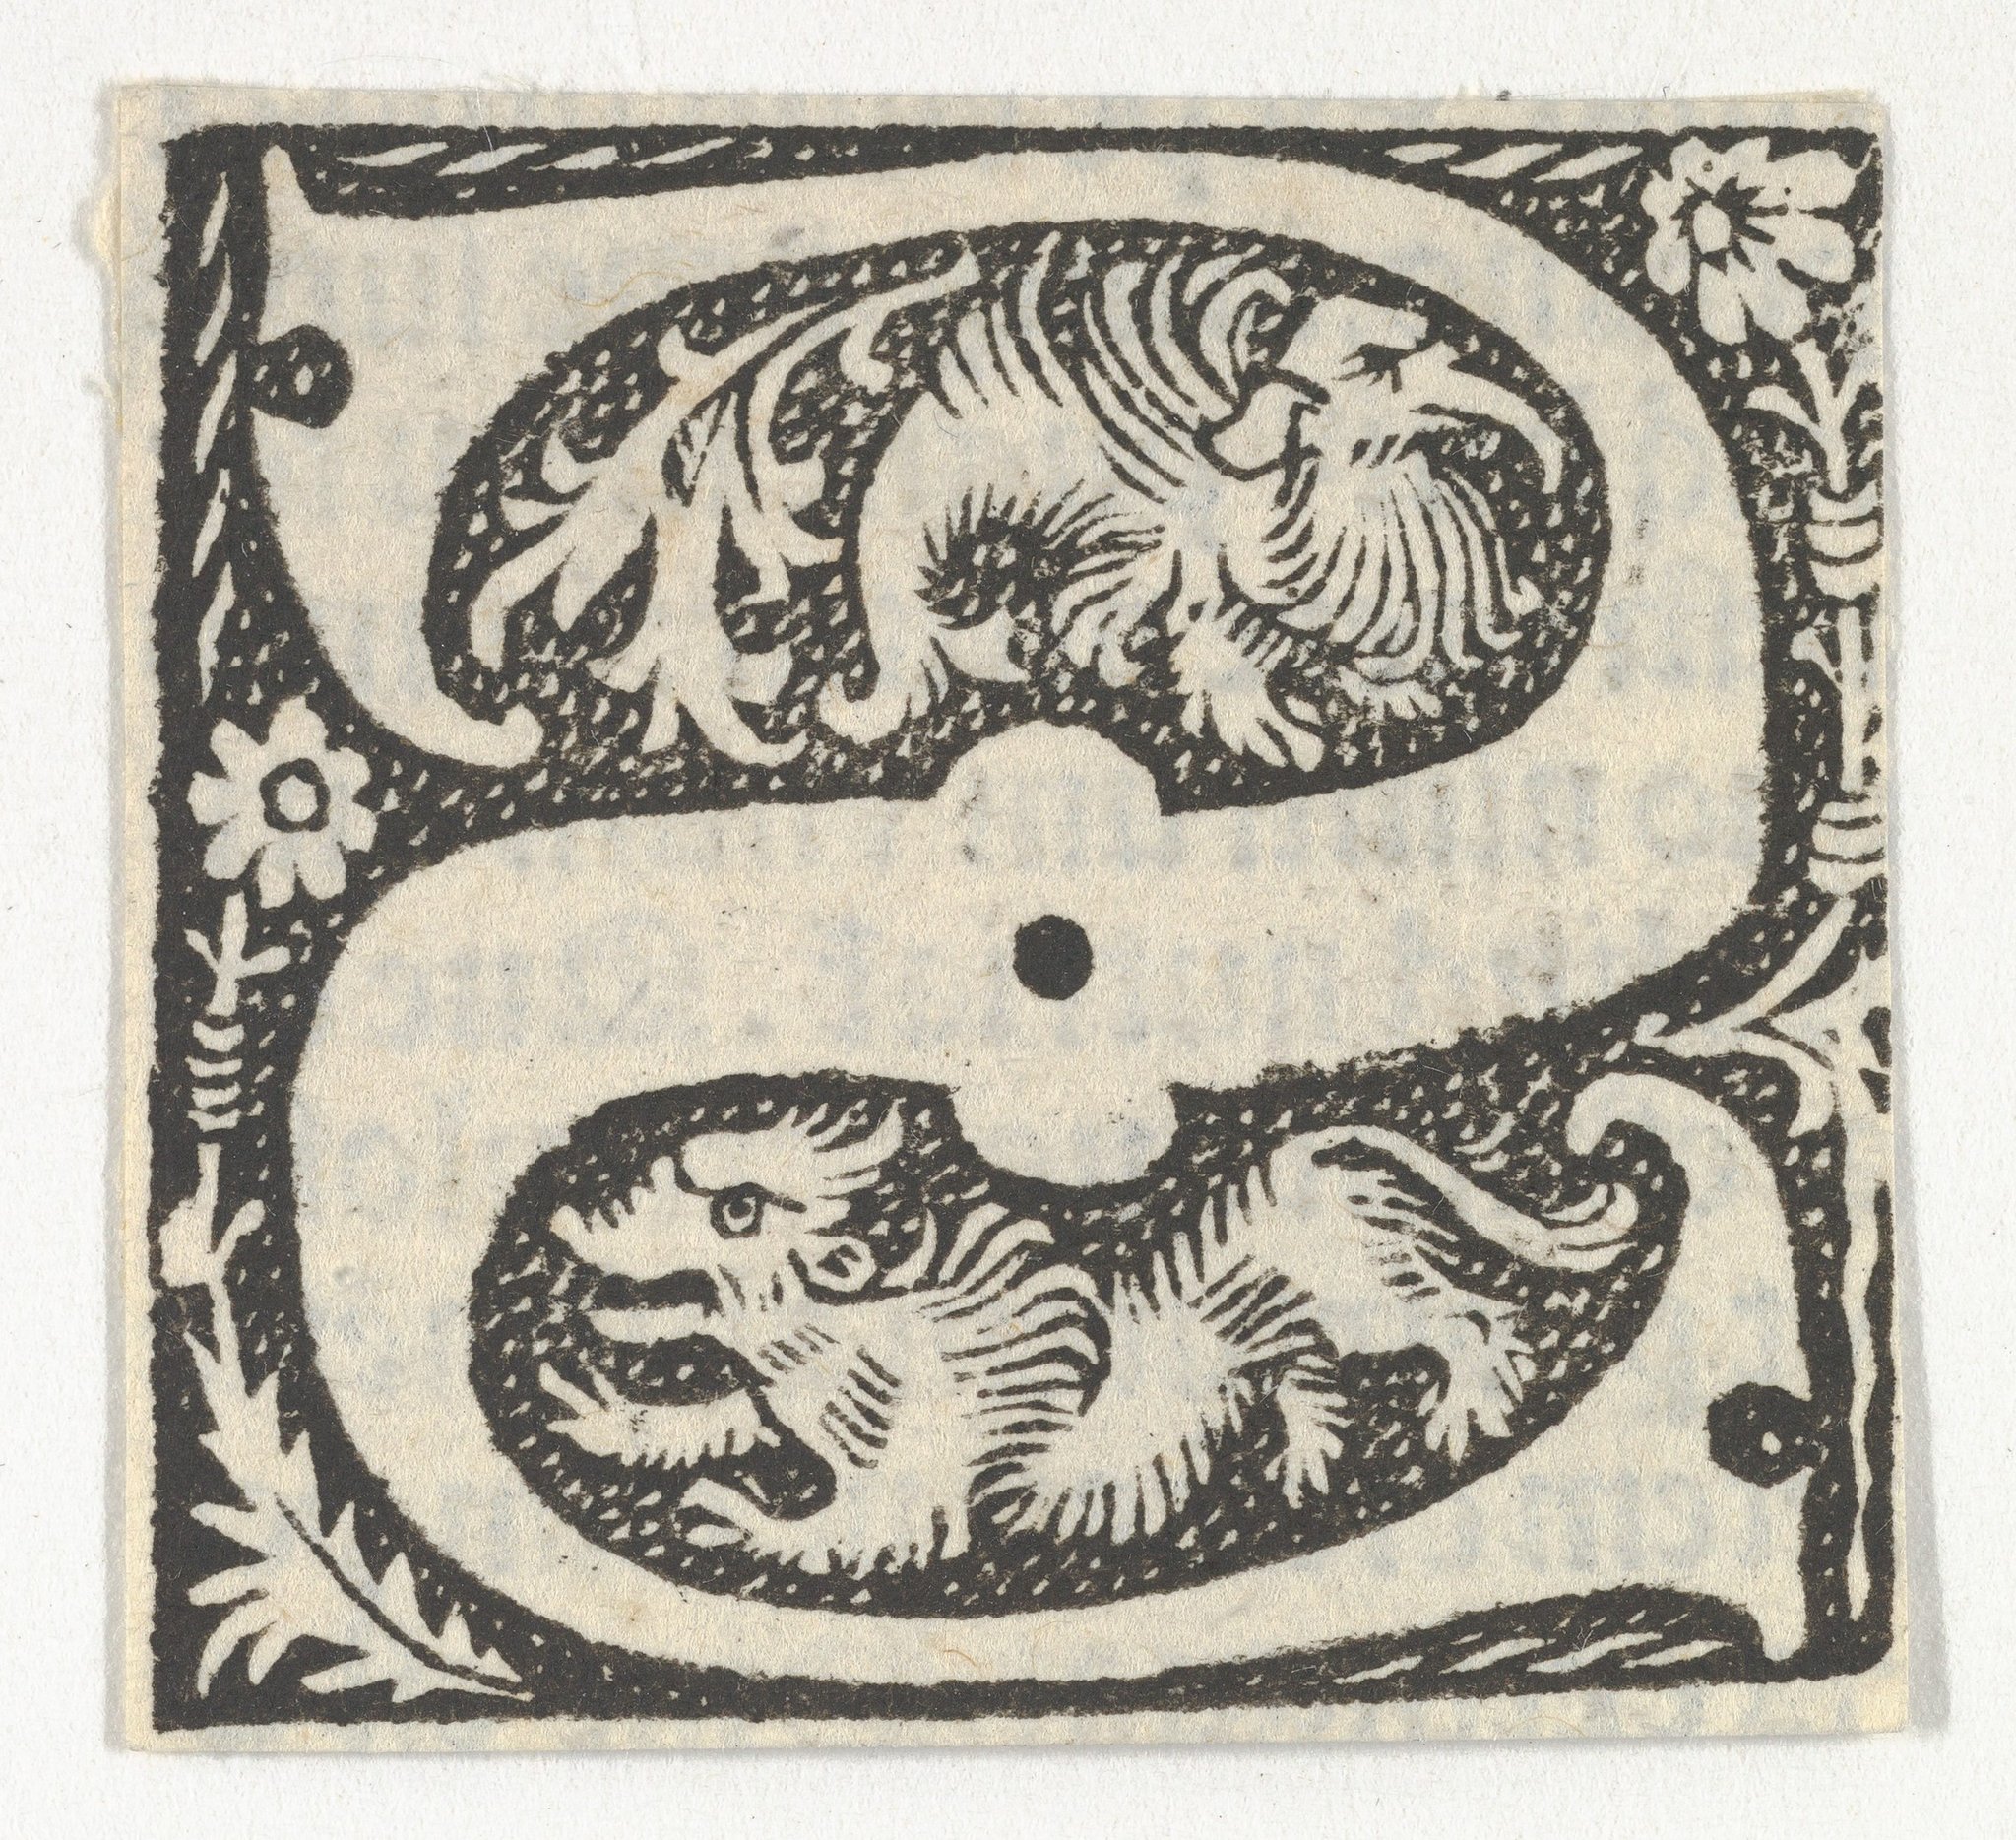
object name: print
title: Decorated Roman alphabet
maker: anonymous, french, 15th century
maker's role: artist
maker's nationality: french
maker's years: 1400-1500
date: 1499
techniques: woodcut